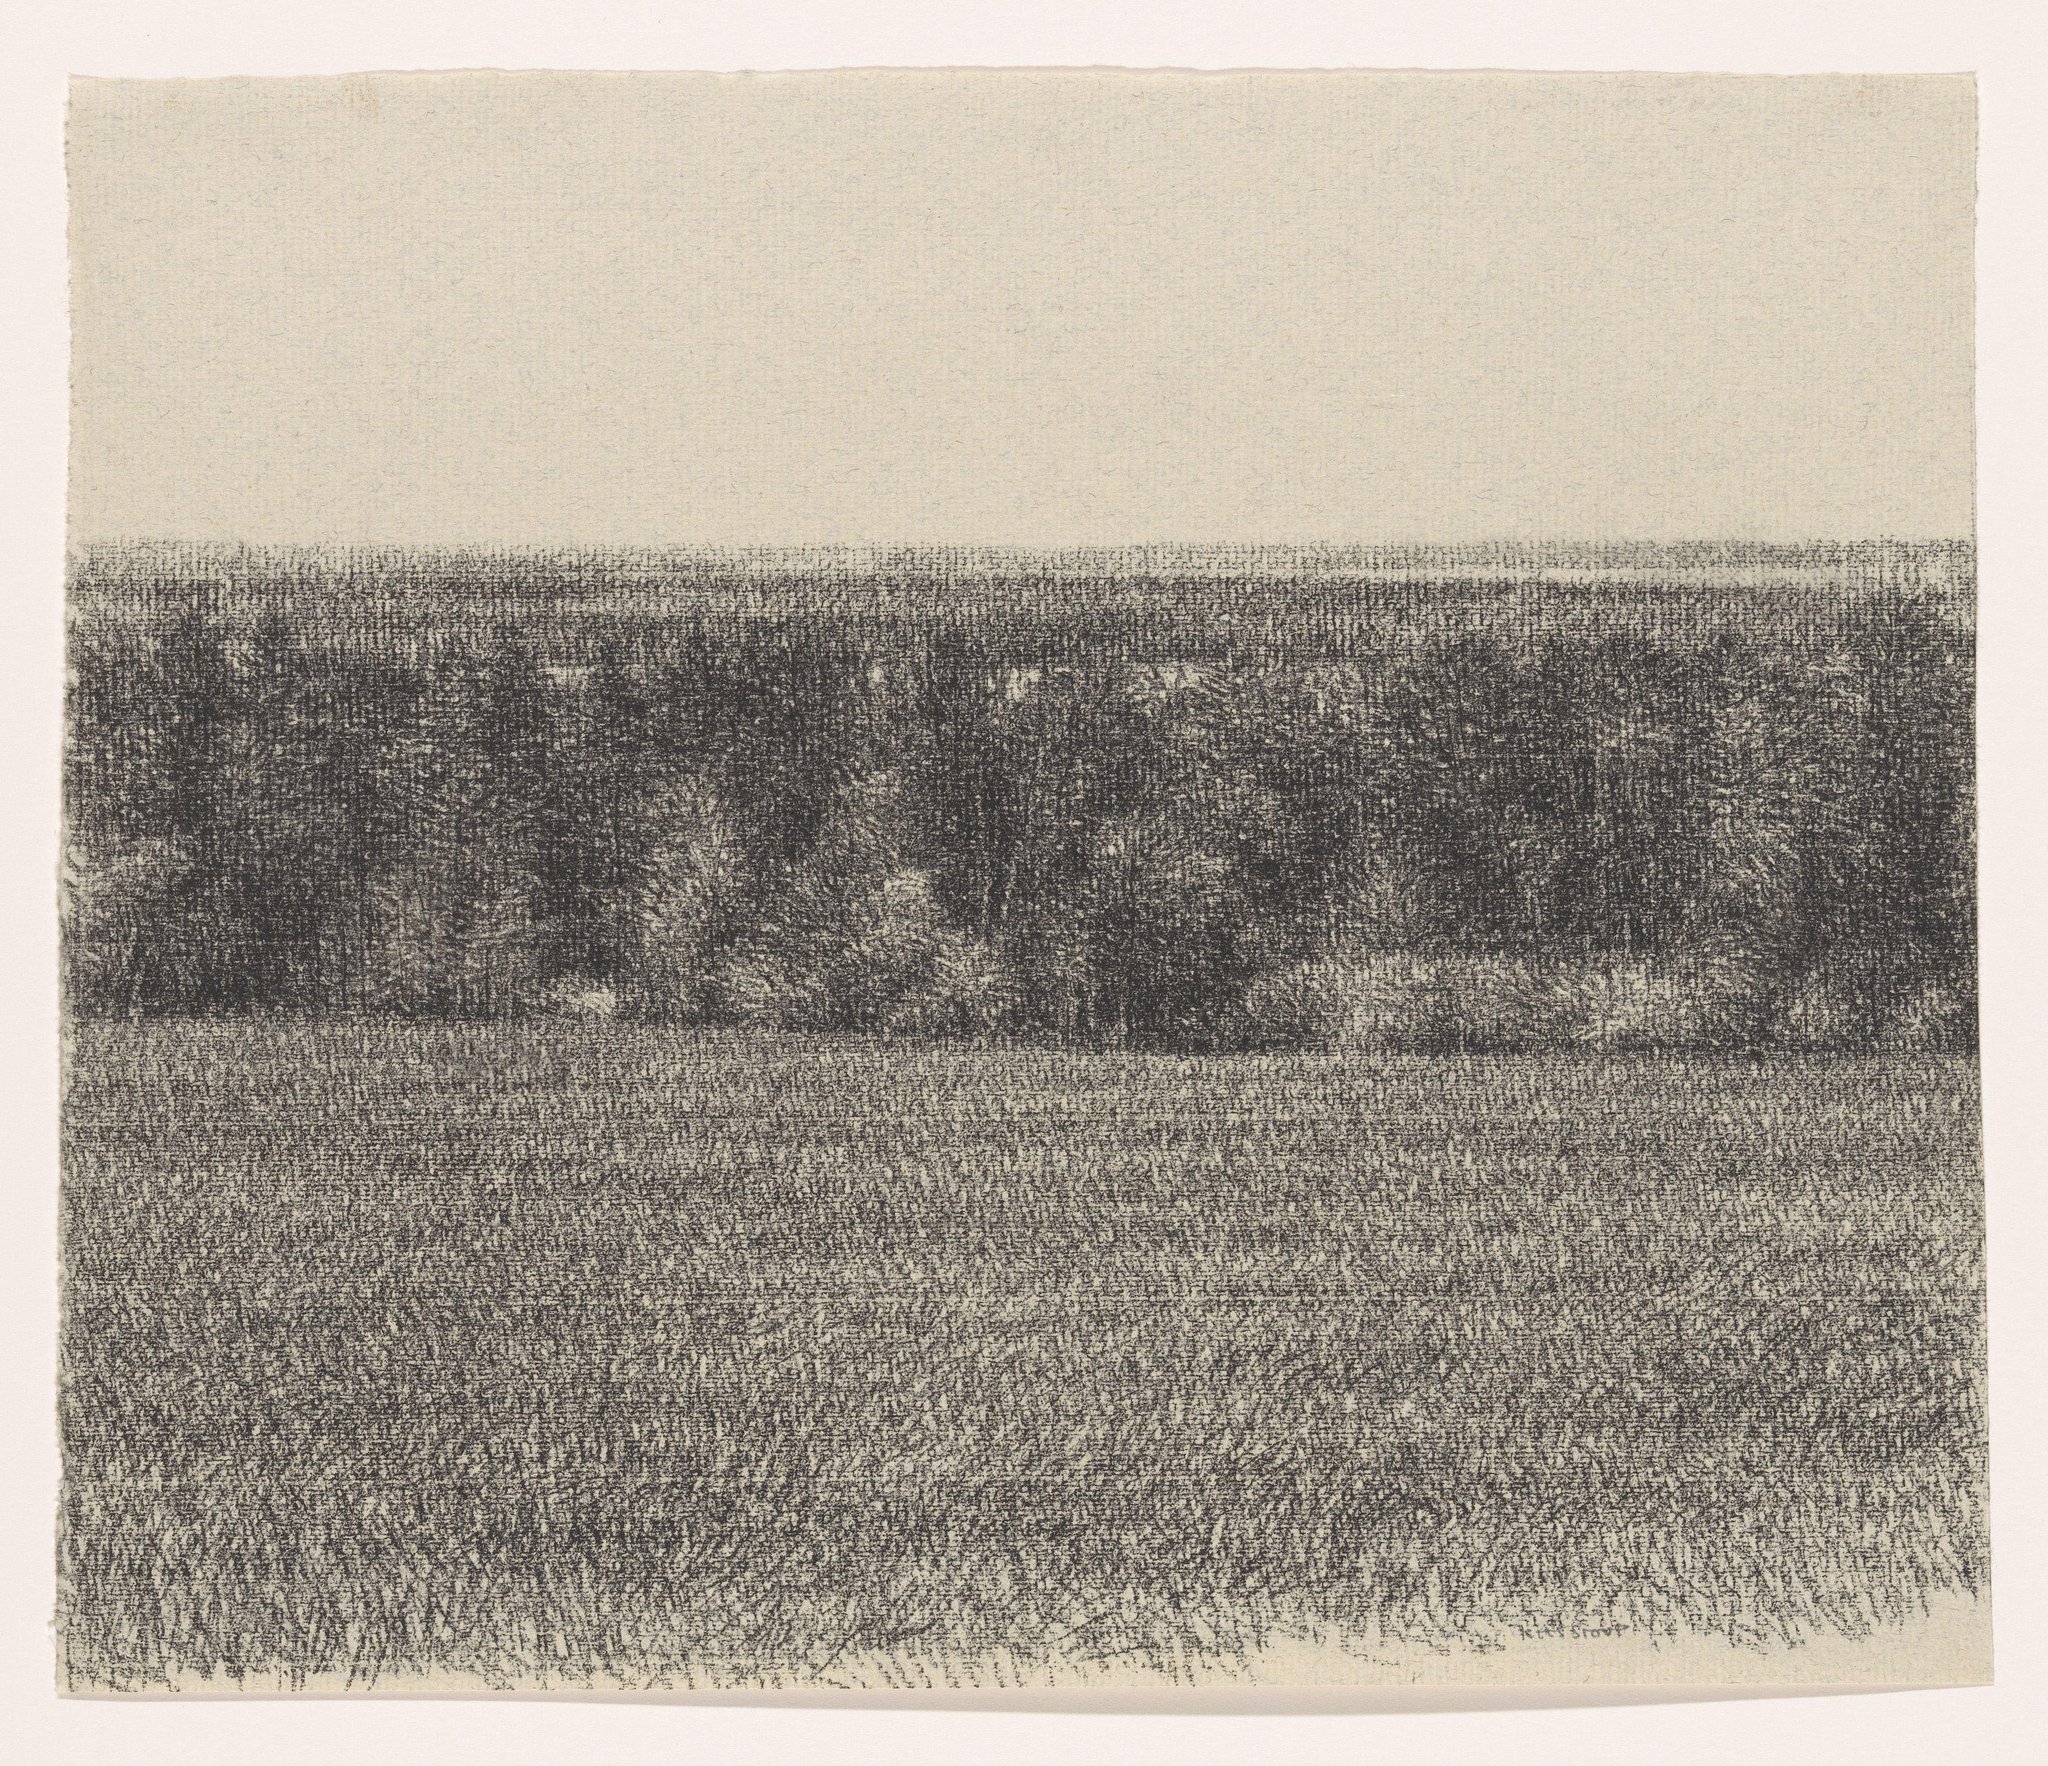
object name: drawing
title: Veld en bosschage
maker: kees stoop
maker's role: draughtsman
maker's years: 1929-2019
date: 1939-2009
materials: charcoal, paper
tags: groups of trees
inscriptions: signature: ‘KEES STOOP’